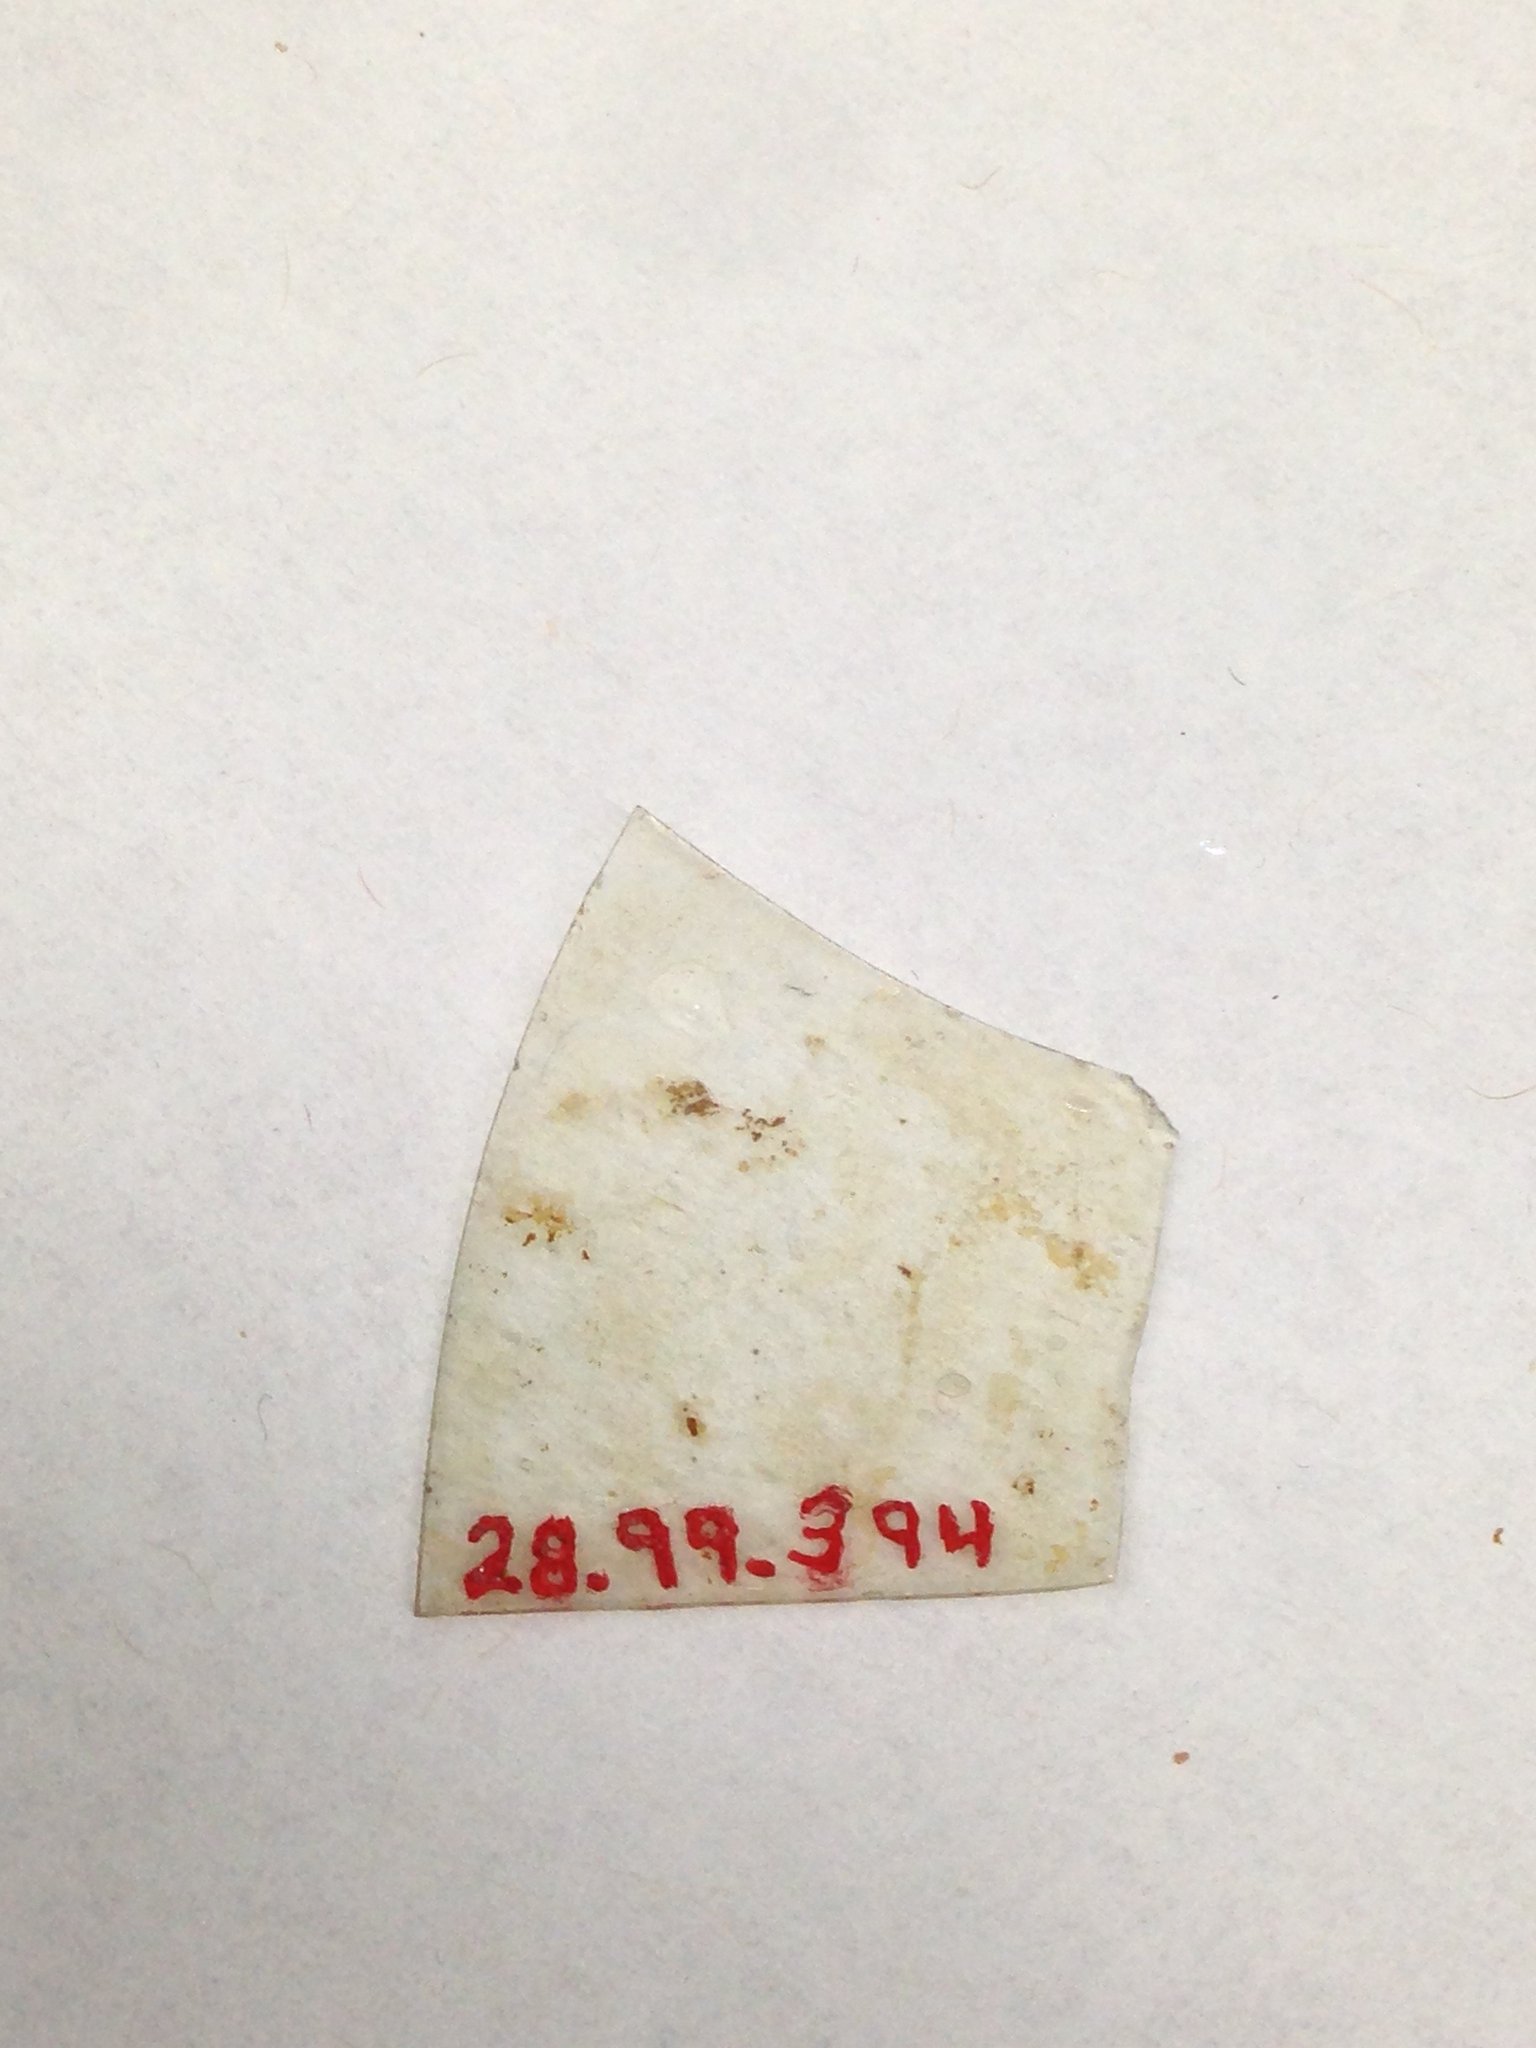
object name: fragment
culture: european or middle eastern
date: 1150-1250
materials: ceramic, glass